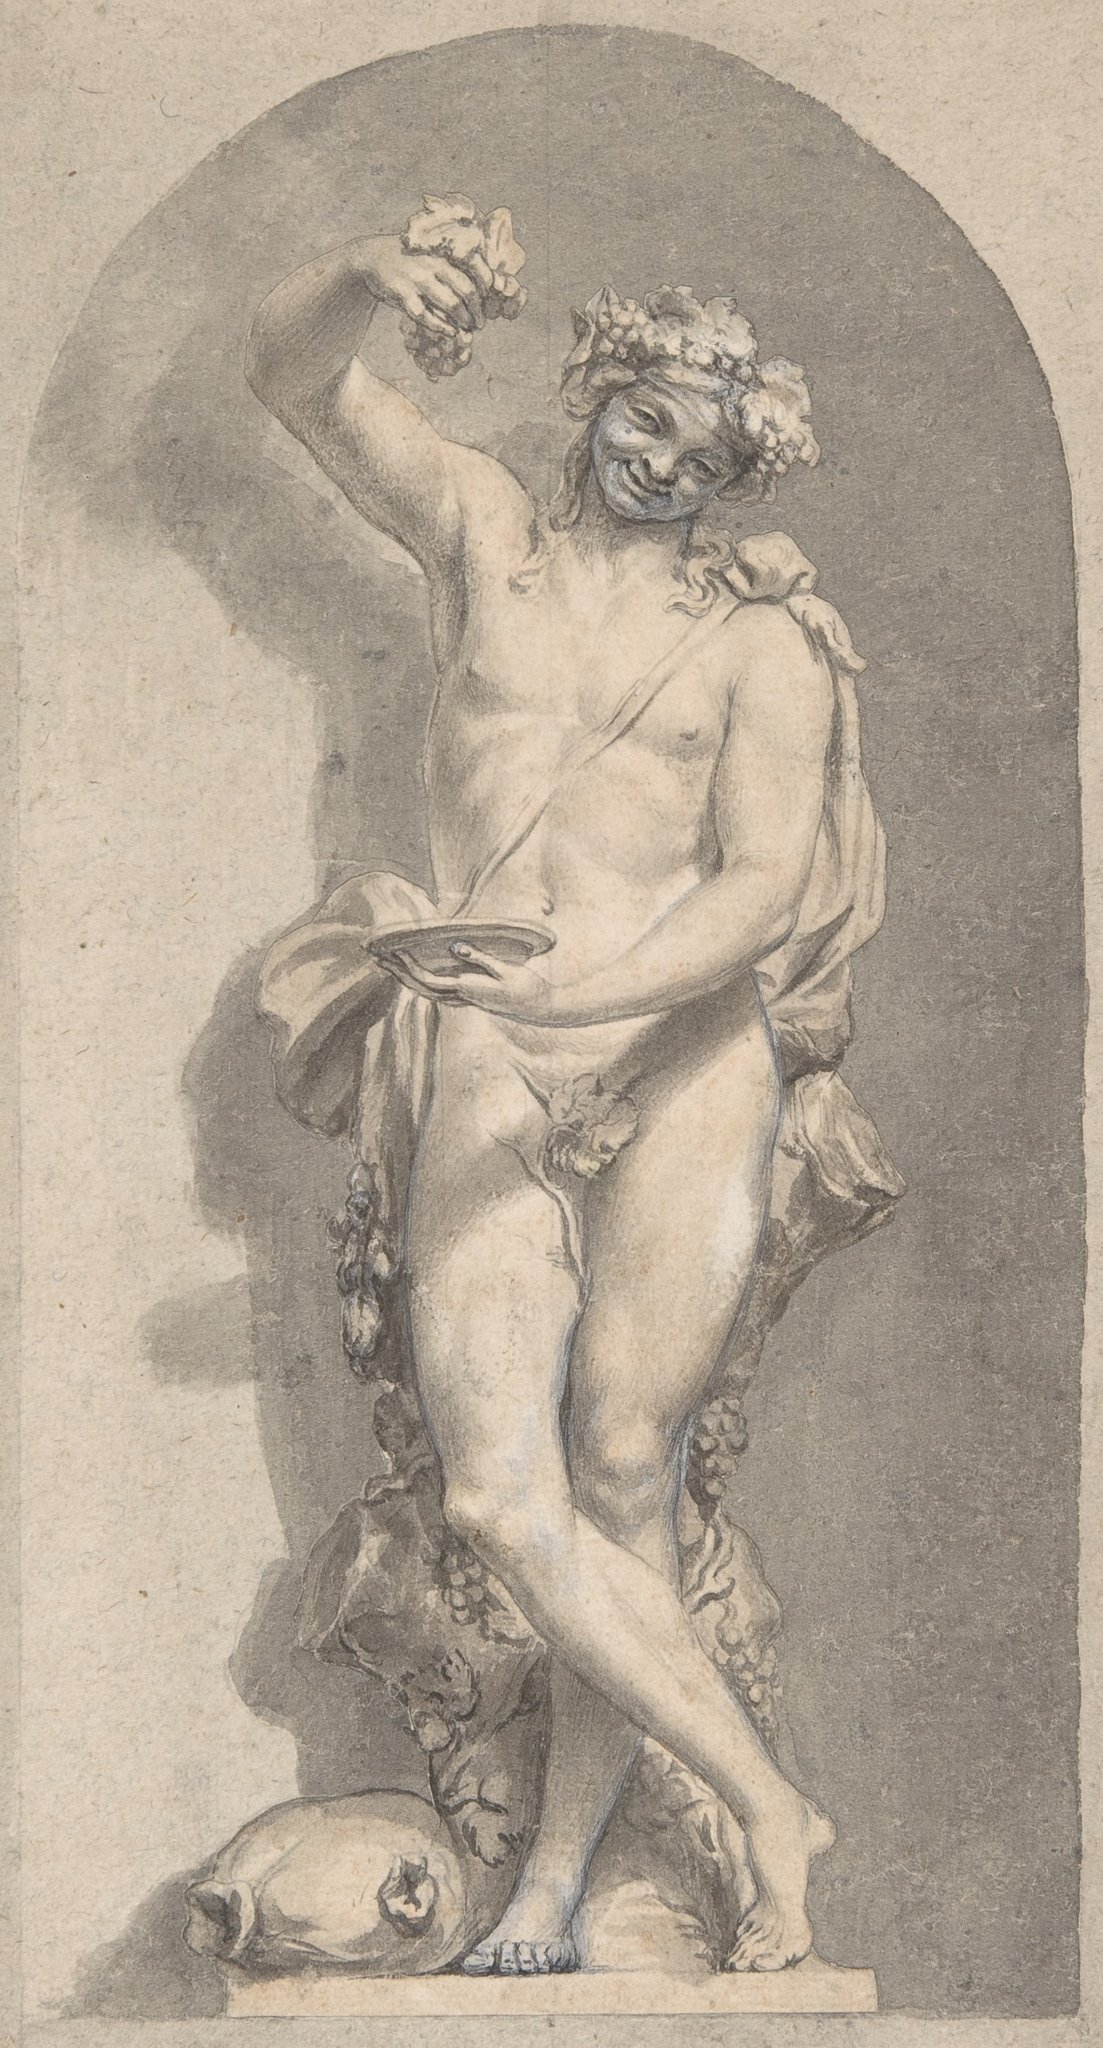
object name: drawing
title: Silhouetted Study of Bacchus in a Niche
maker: anonymous, italian, 18th century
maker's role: artist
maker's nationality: italian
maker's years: 1700-1800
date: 1701-1800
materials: chalk, gouache, ink, paper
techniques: brush, cutting, drawing, highlighting, pen, wash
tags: grapes,bacchus,leaves